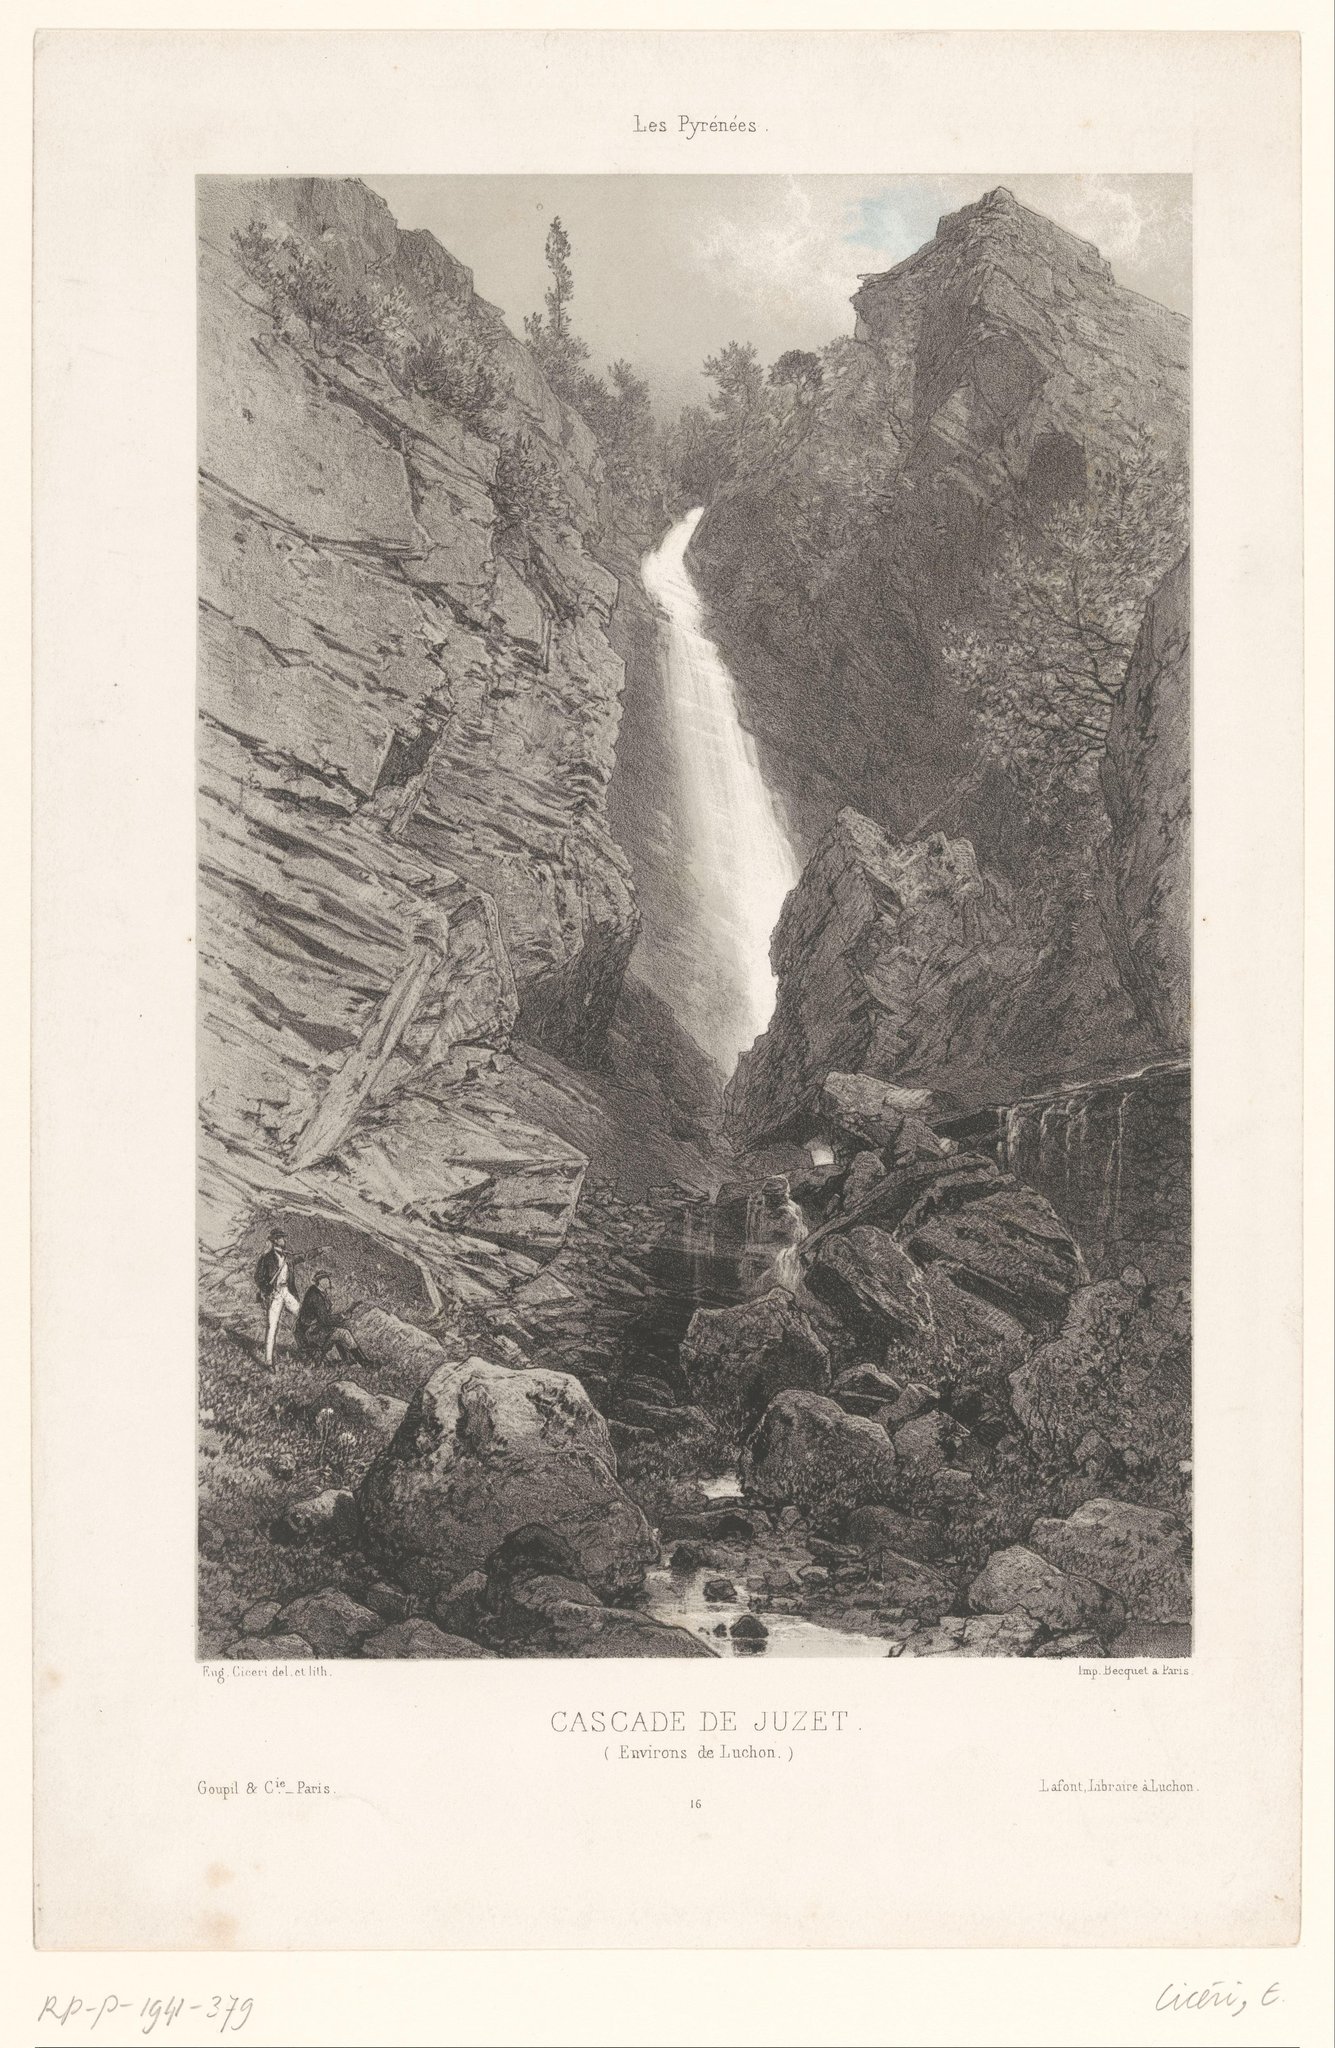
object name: print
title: Les Pyrénées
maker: eugène cicéri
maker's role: print maker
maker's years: 1813-1890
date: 1858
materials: paper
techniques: tone lithography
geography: paris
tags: waterfall (+ landscape with figures, staffage), mountains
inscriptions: collector's mark: Lugt 2228a, collector's mark: Lugt 2760